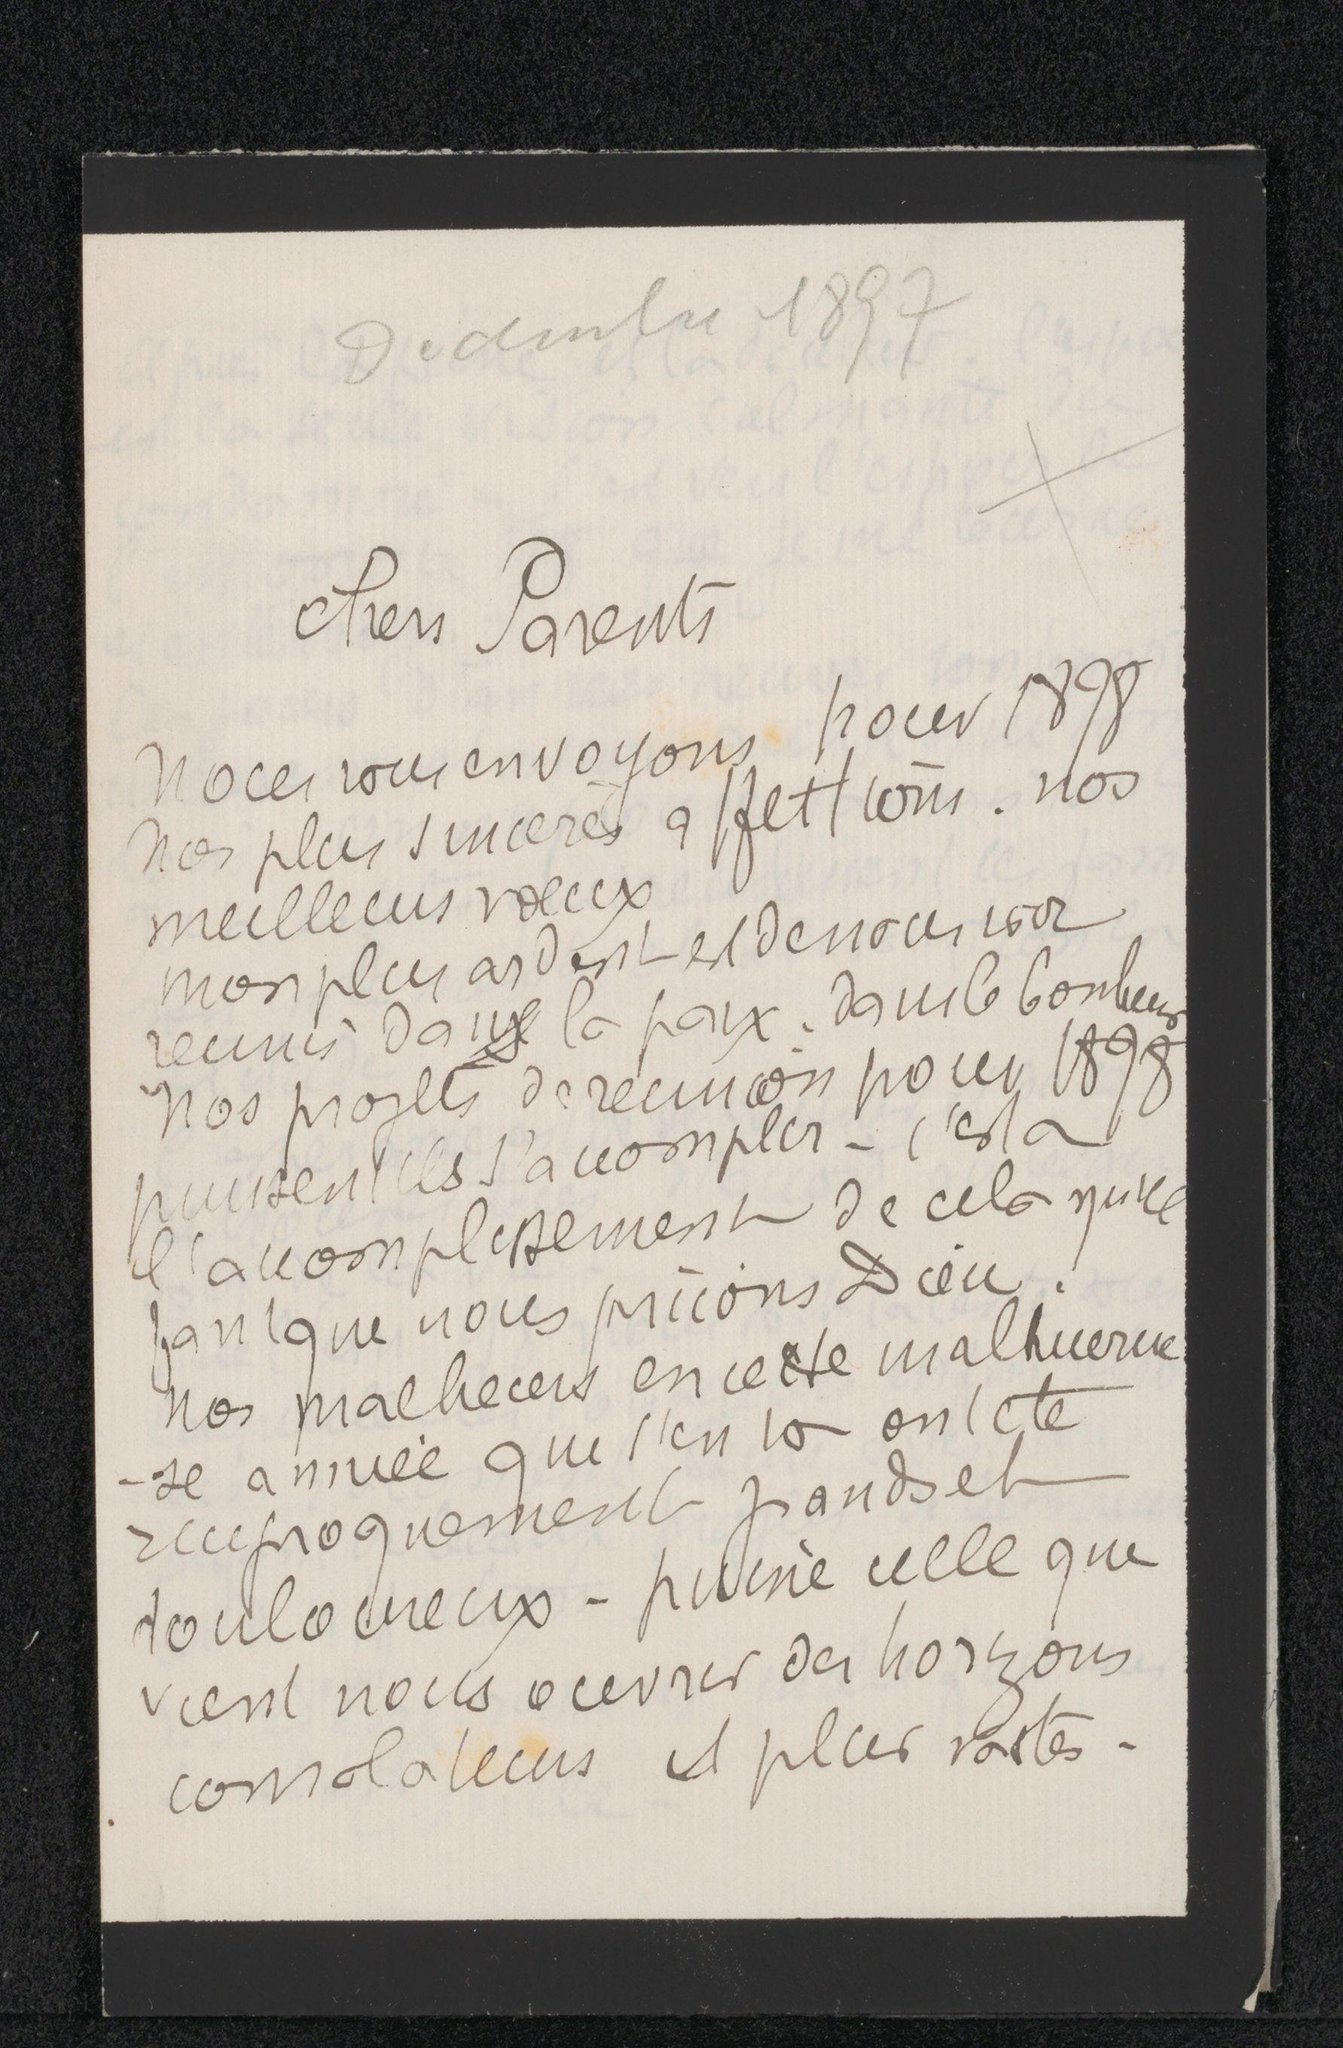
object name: letter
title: Brief aan Emile Ernest Bernard en Héloïse Bernard-Bodin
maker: émile bernard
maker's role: print maker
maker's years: 1868-1941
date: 1878-1941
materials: ink, paper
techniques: pen, writing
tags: héloïse bernard-bodin, emile ernest bernard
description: Brief gedateerd Decembre 1897 in latere hand.